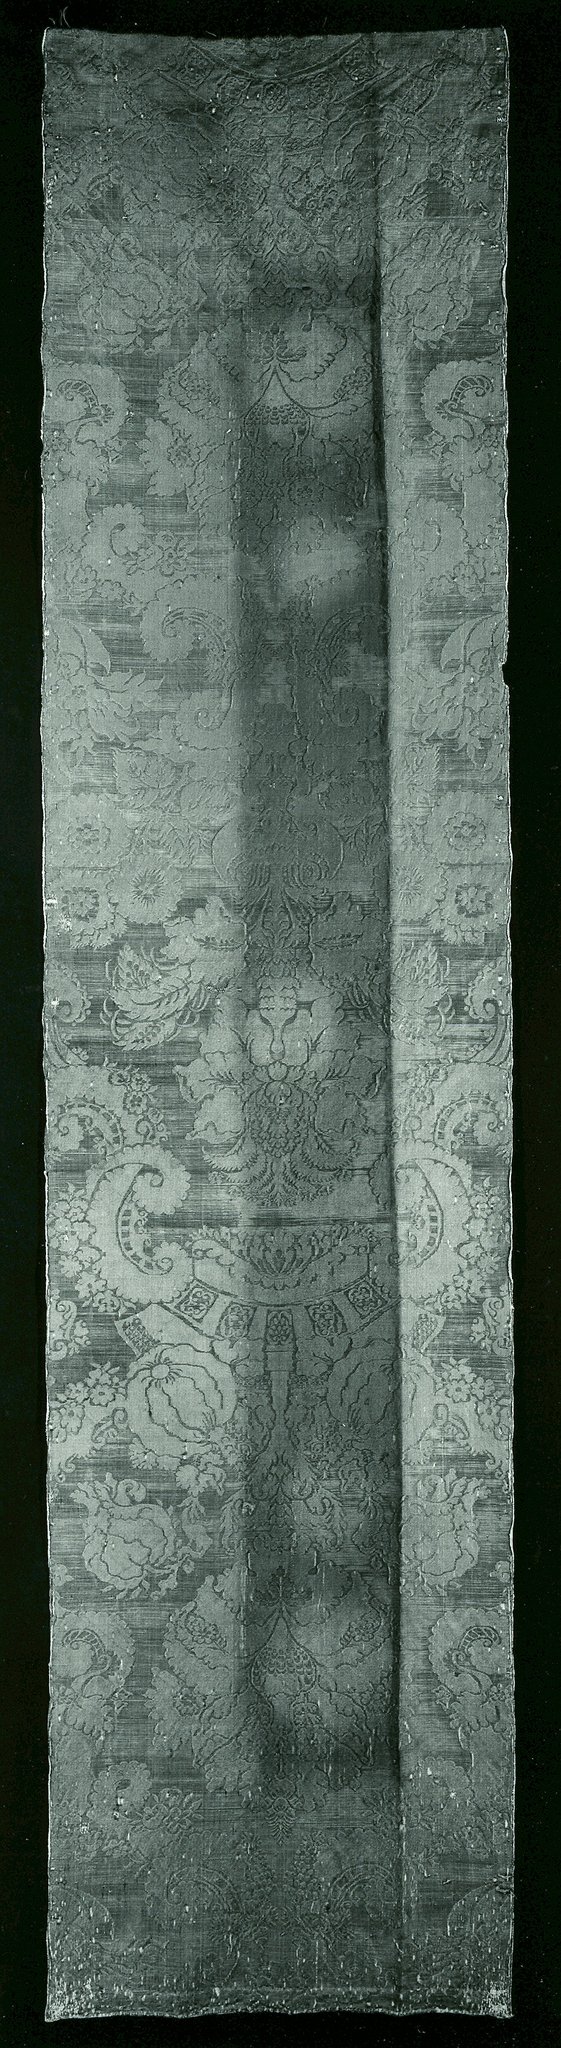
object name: textile panel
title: Panel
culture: italian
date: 1601-1700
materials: linen, silk